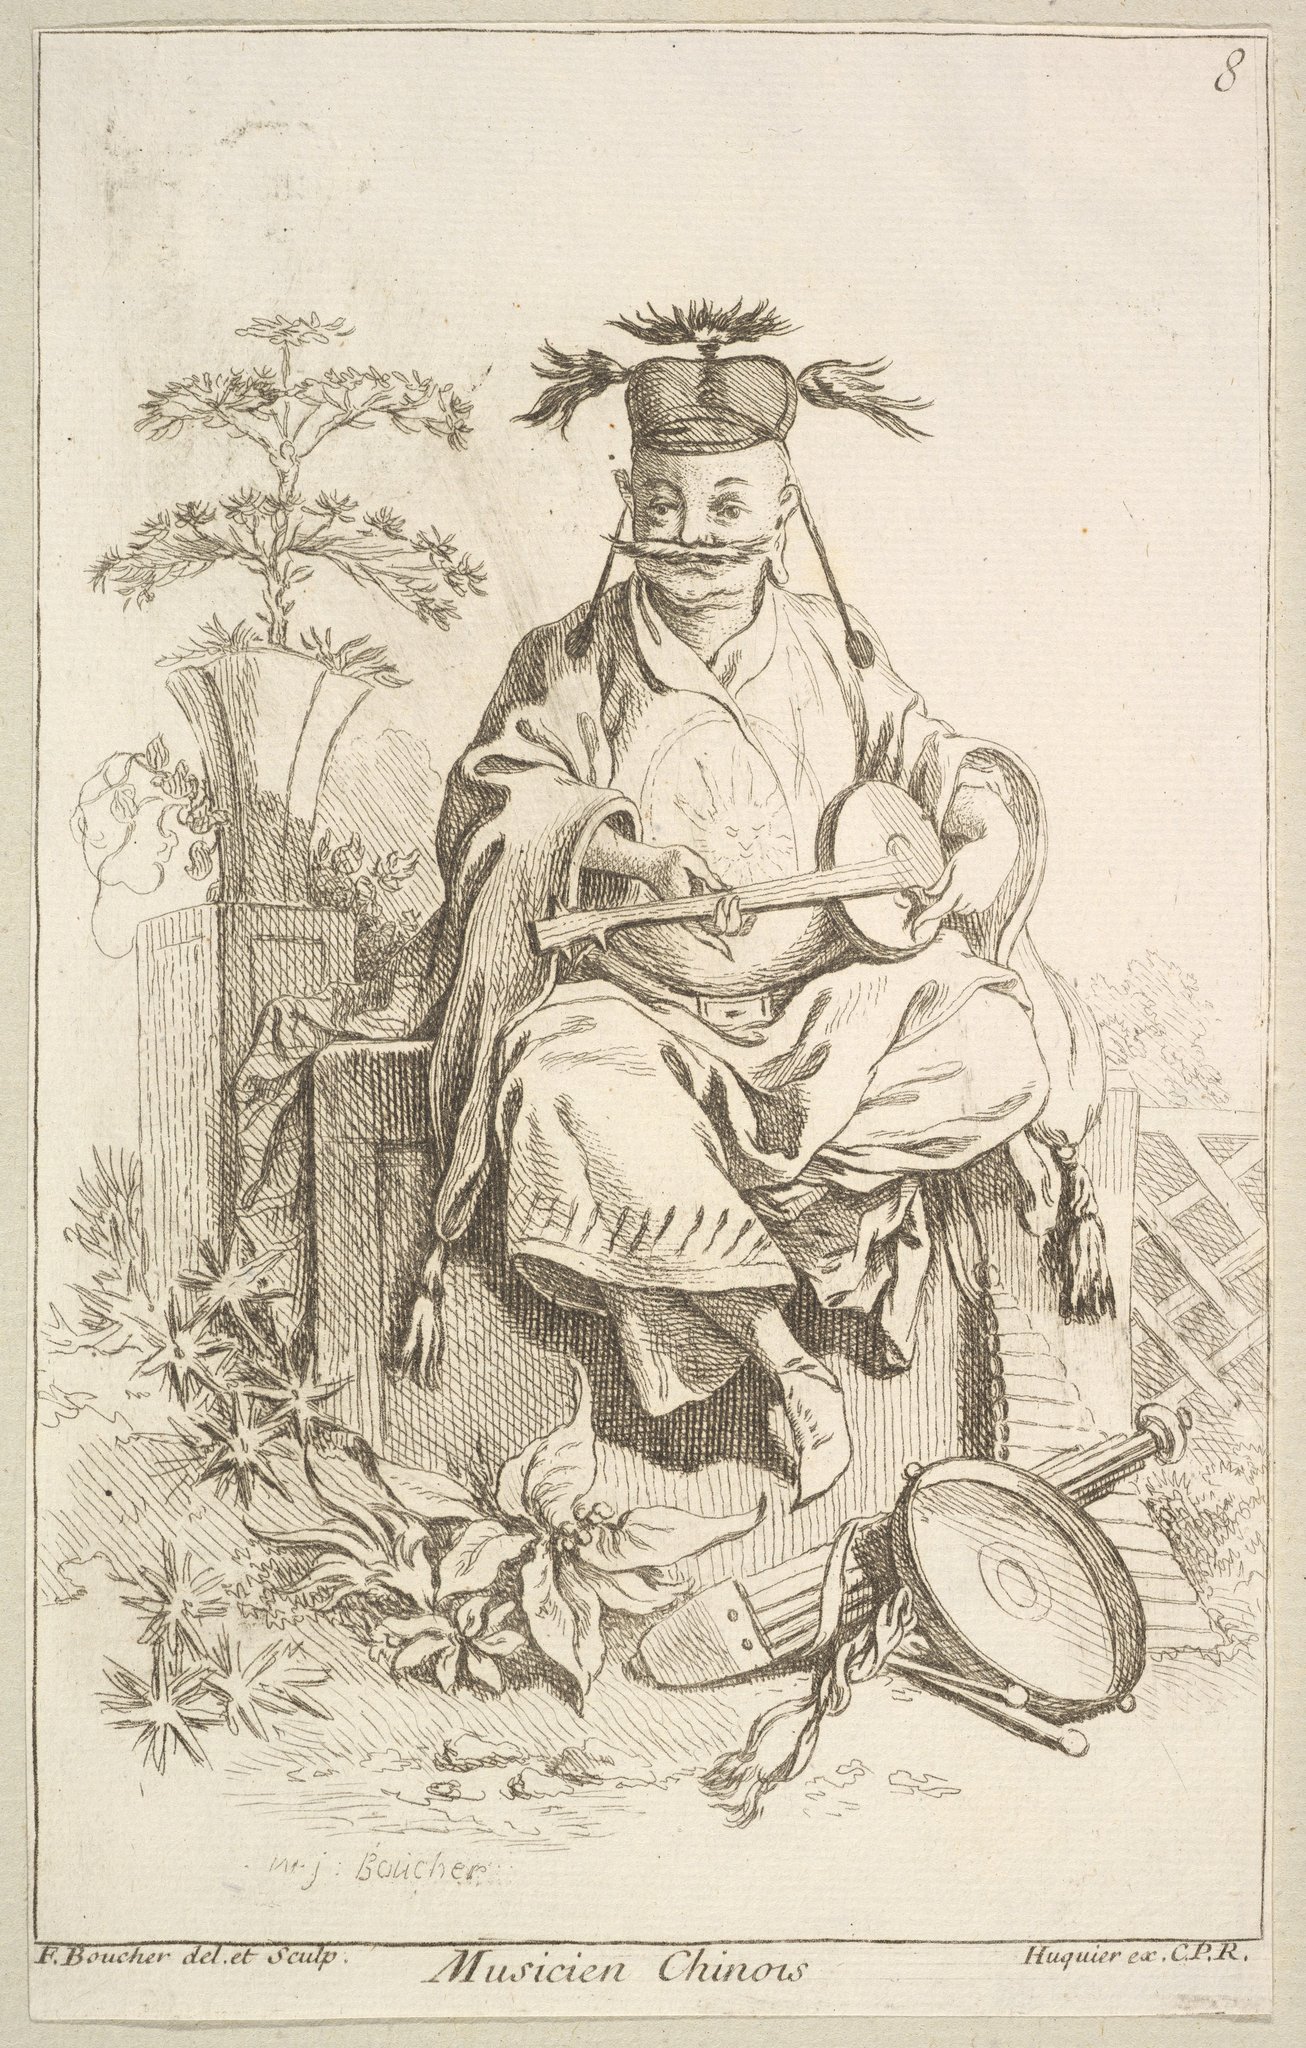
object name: print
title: Chinese Musician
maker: françois boucher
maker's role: artist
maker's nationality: french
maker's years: 1703-1770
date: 1738-1745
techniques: etching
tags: musical instruments,men,musicians